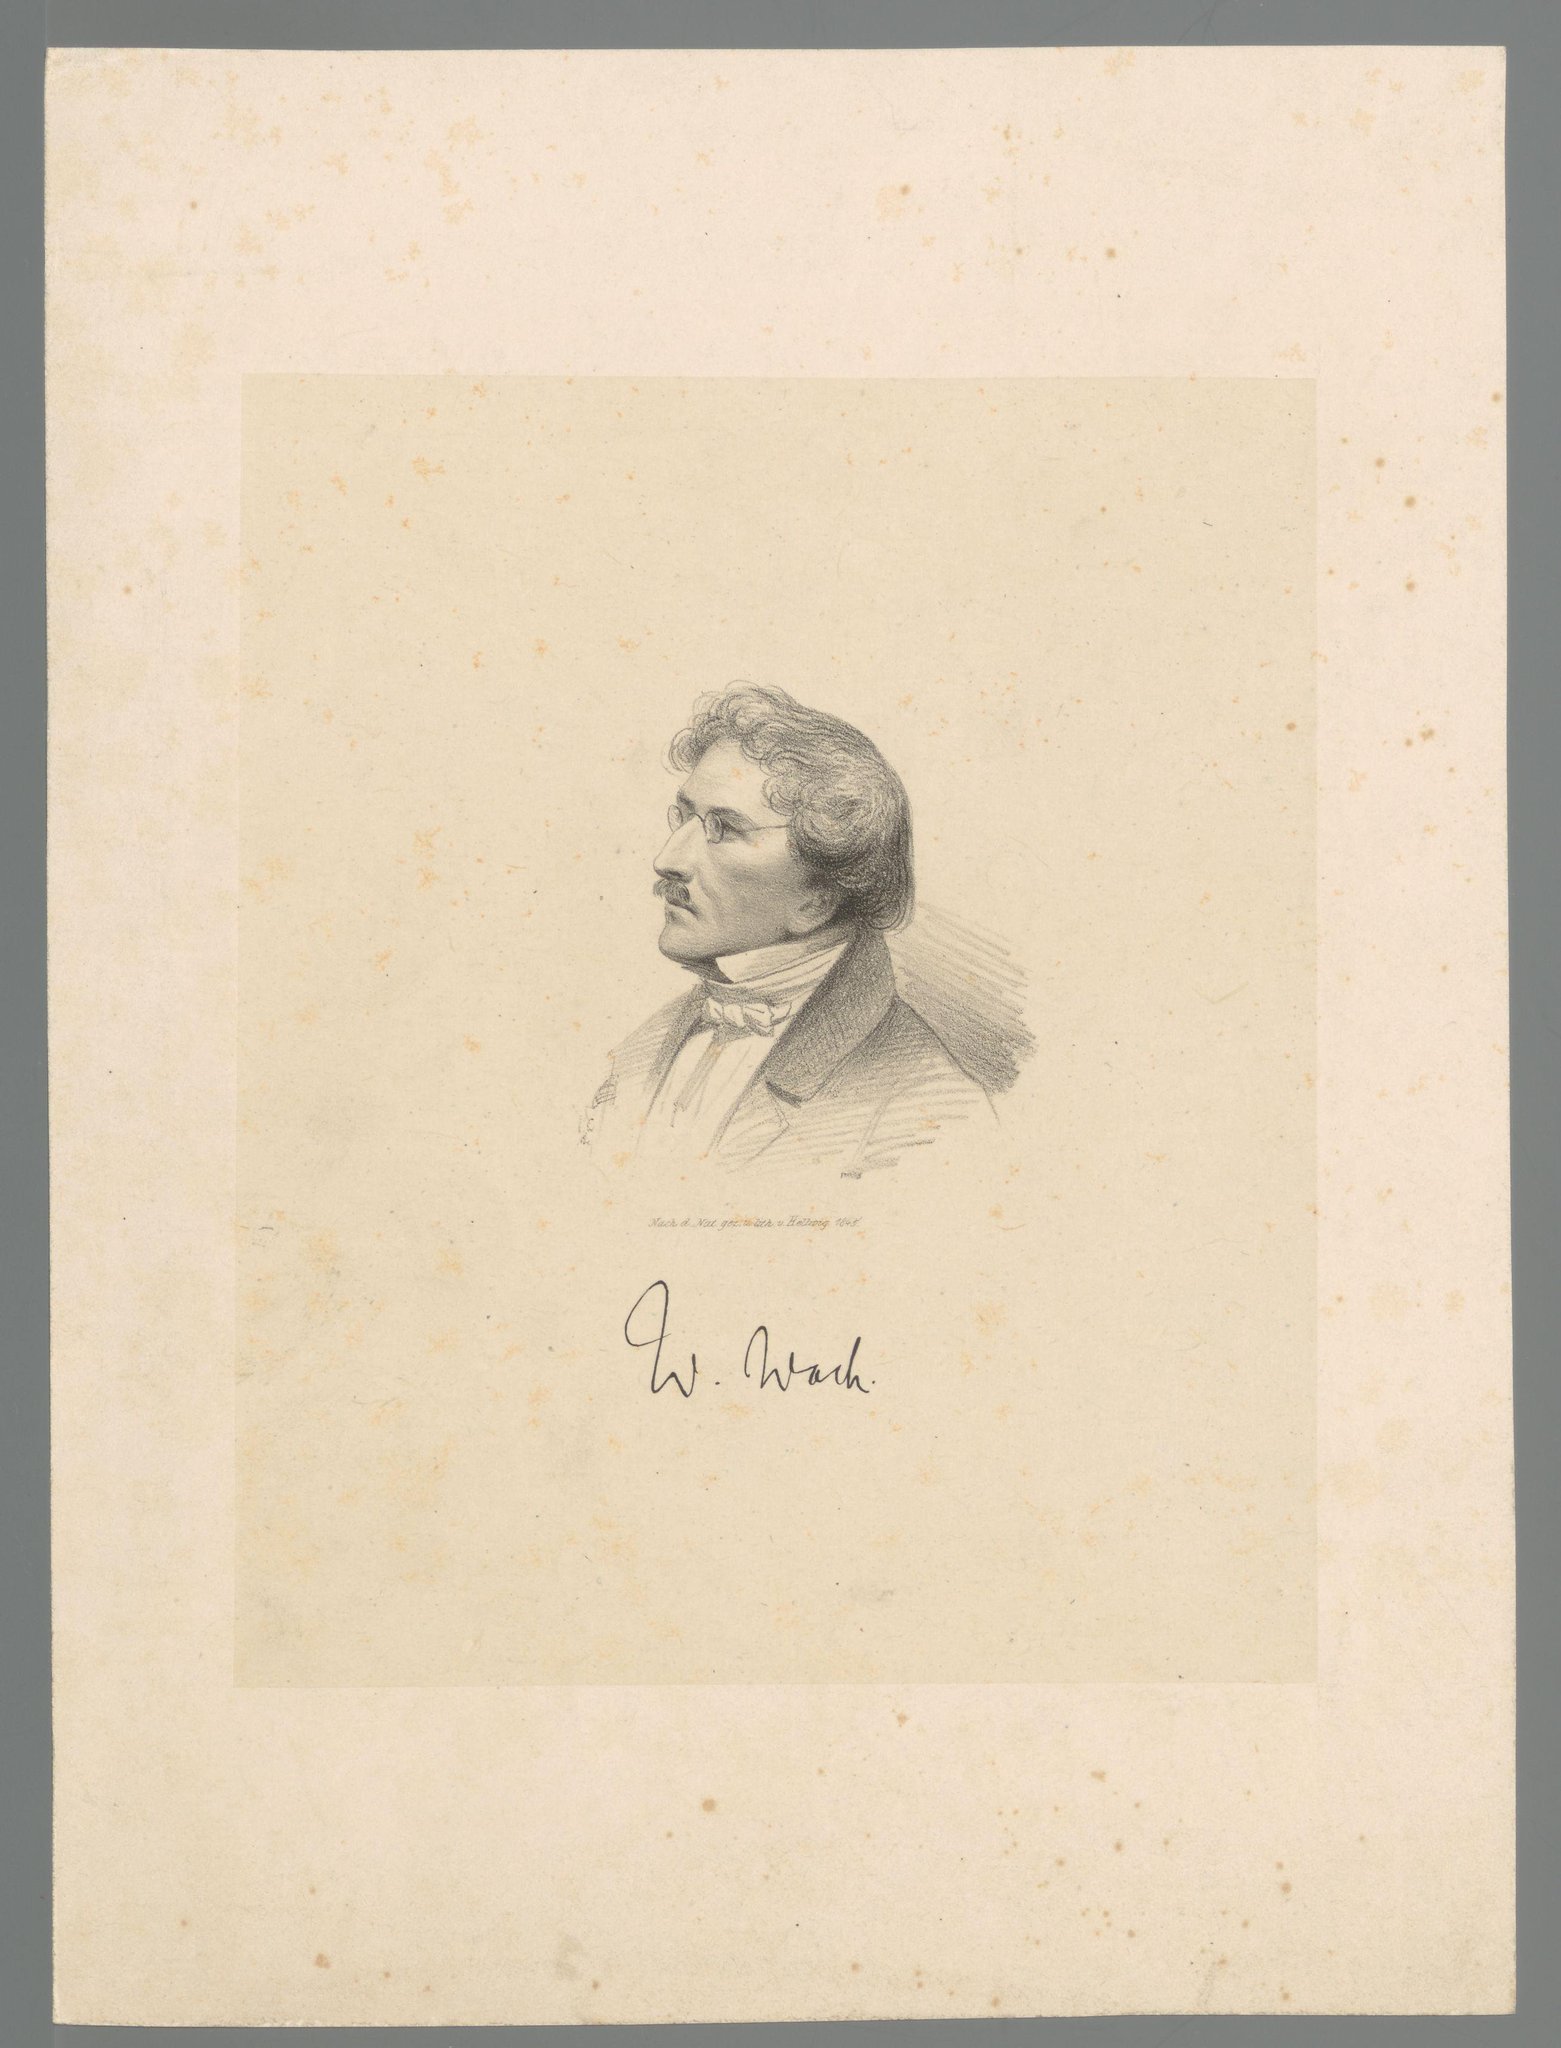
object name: print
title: Portret van Wilhelm Wach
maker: theodor hellwig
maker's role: print maker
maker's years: 1815-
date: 1845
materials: paper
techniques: lithograph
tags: painter, wilhelm wach, historical persons, portrait, self-portrait of painter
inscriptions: collector's mark: Lugt 2228